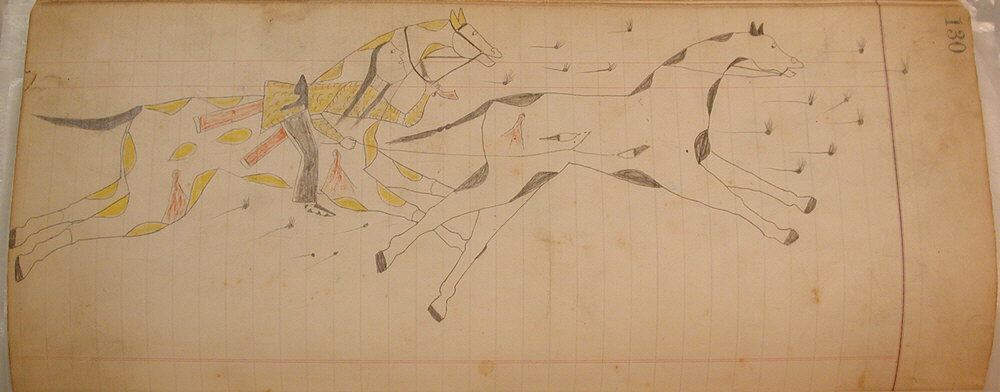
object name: drawing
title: Maffet Ledger: Drawing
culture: cheyenne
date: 1874-1881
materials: crayon, graphite, paper, watercolor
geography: united states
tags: human figures,horses